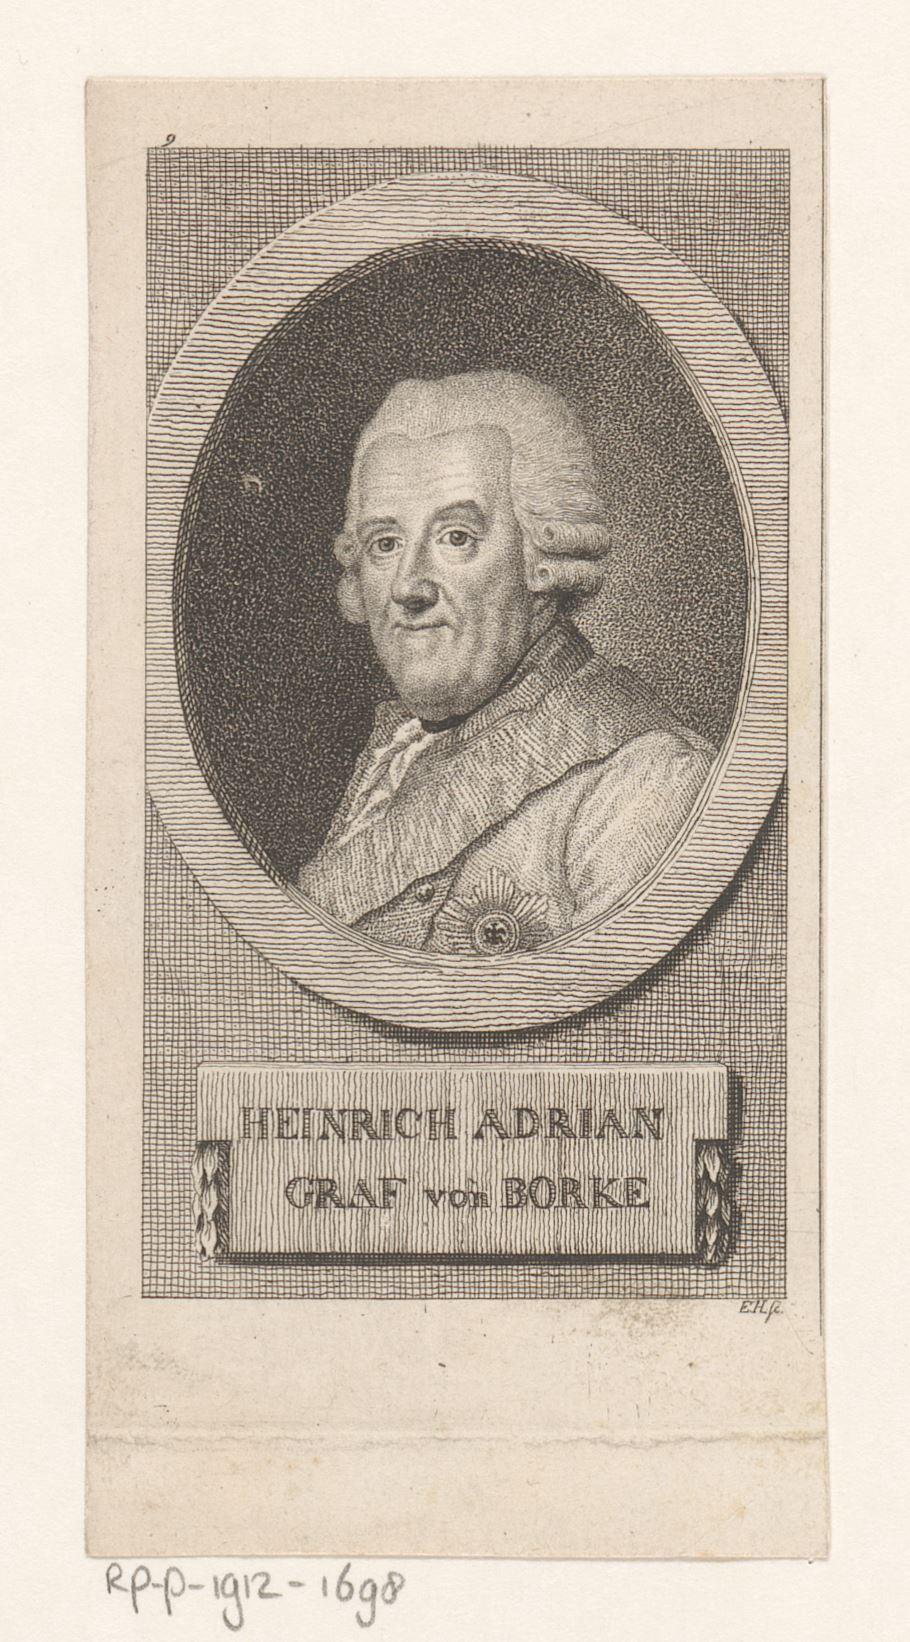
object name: print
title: Portret van Heinrich Adrian Graf von Borcke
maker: eberhard siegfried henne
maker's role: print maker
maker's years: 1759-1828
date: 1769-1828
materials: paper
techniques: etching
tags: knighthood order (with name) - insignia of a knighthood order, e.g.: badge, chain (with name of order), historical persons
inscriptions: collector's mark: Lugt 2228